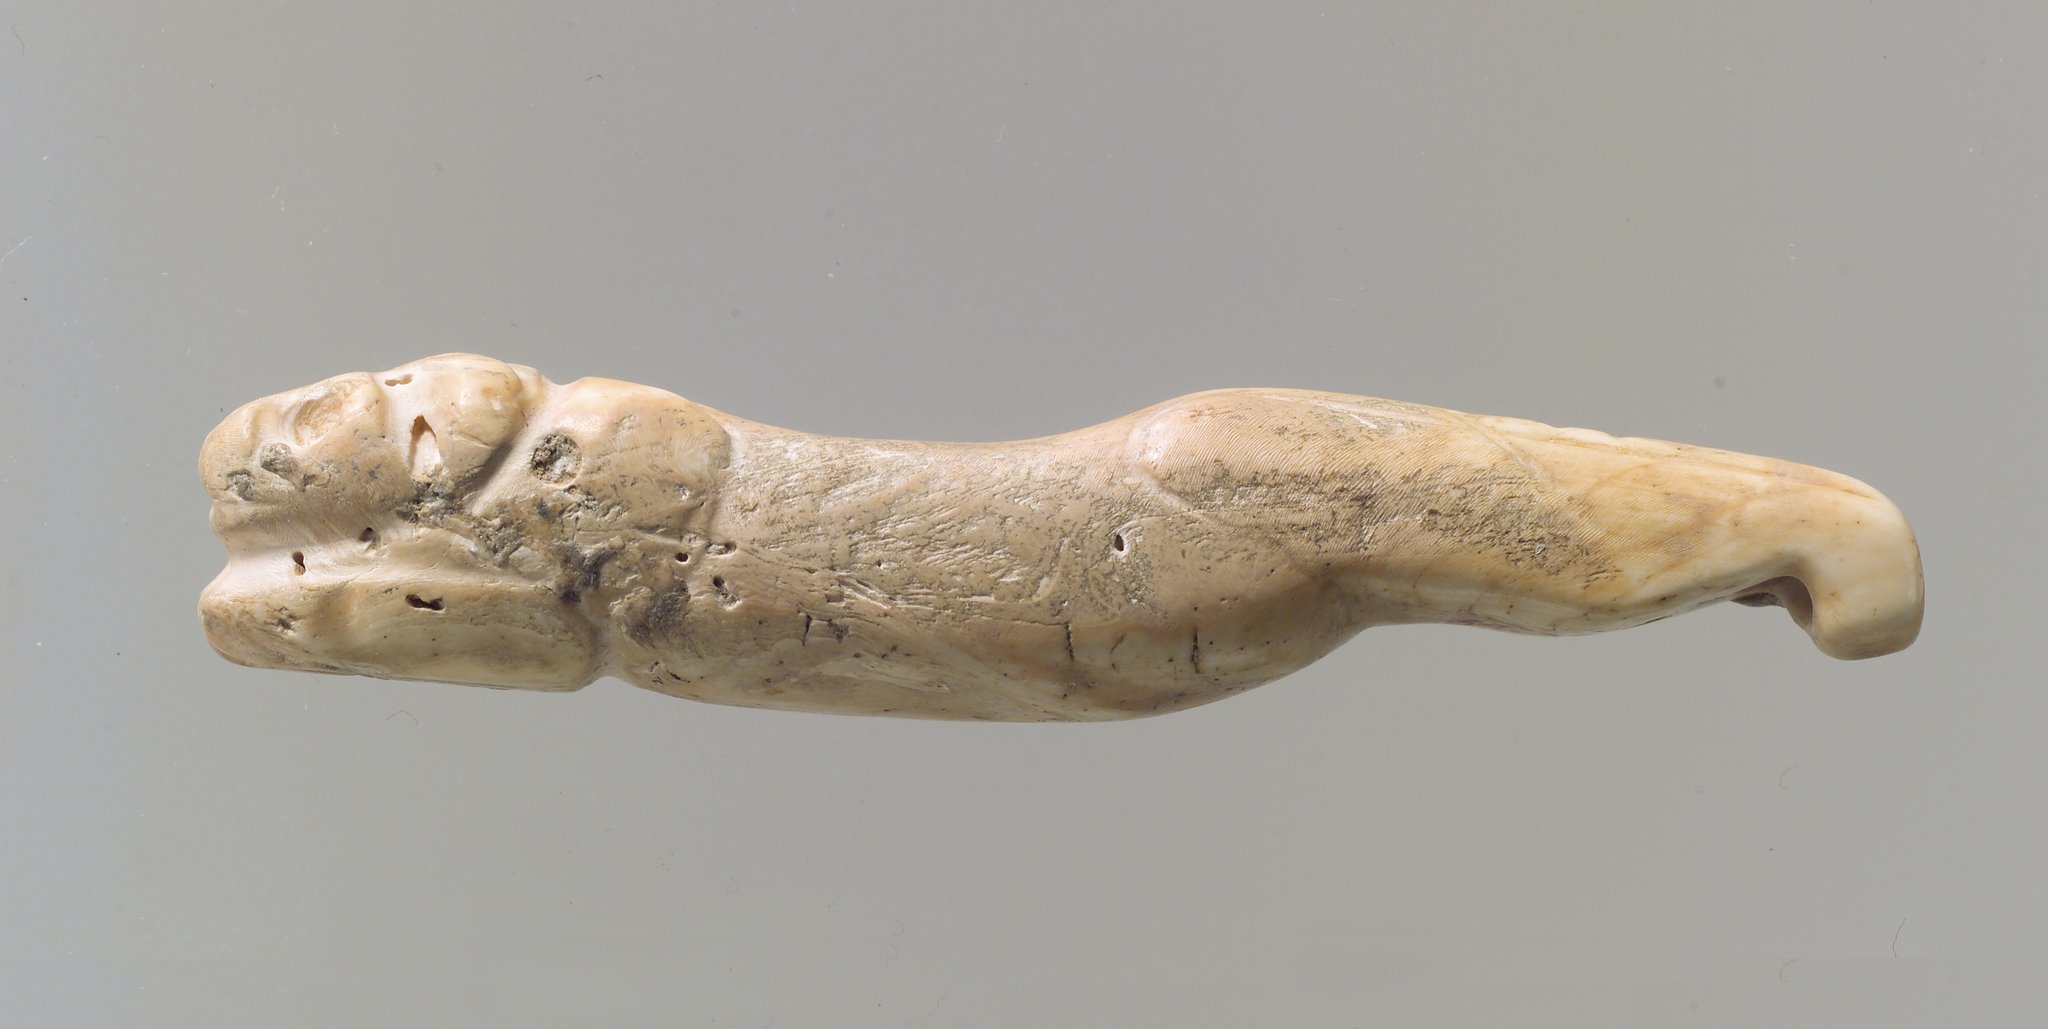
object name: necklace, bead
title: Amulet in the form of a lion with legs extended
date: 3300-2900 BCE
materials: shell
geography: southern mesopotamia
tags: lions